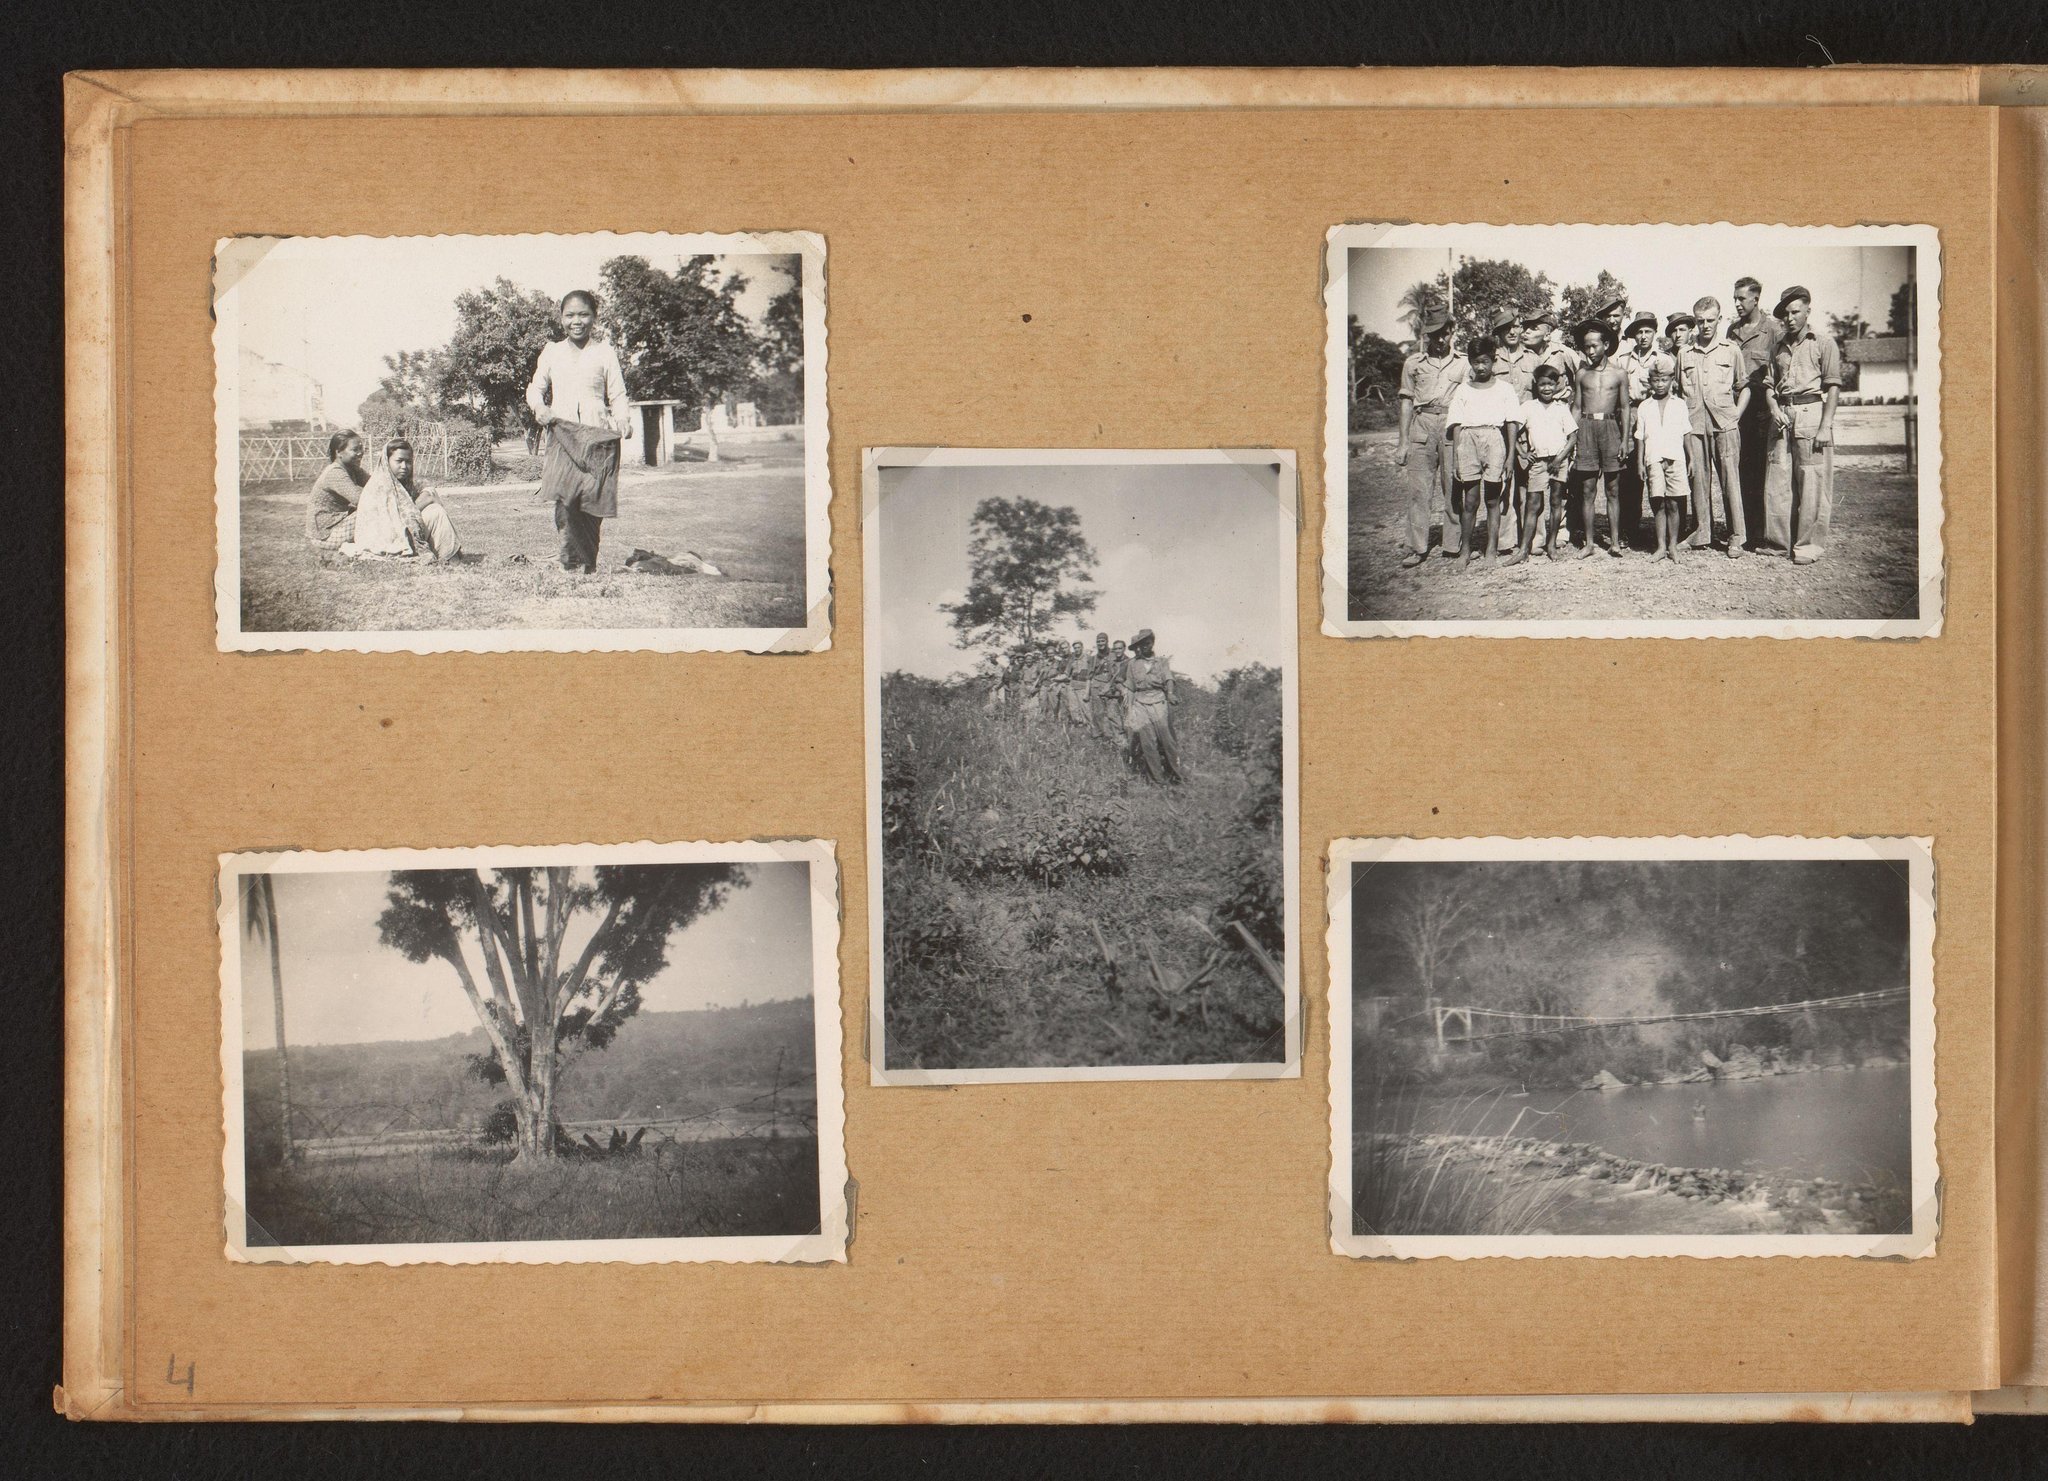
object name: album leaf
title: Militairen en lokale bevolking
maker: Anonymous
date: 1948-1949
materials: paper, photographic support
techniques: gelatin silver print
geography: dutch east indies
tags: the company, the unit, the troop ~ military service, public road, dutch east indies, the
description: Albumblad met vijf foto's van Nederlandse militairen met de lokale bevolking en enkele landschappen. Onderdeel van het fotoalbum 'Ter herinnering aan mijn diensttijd overzee' 1948-1949.